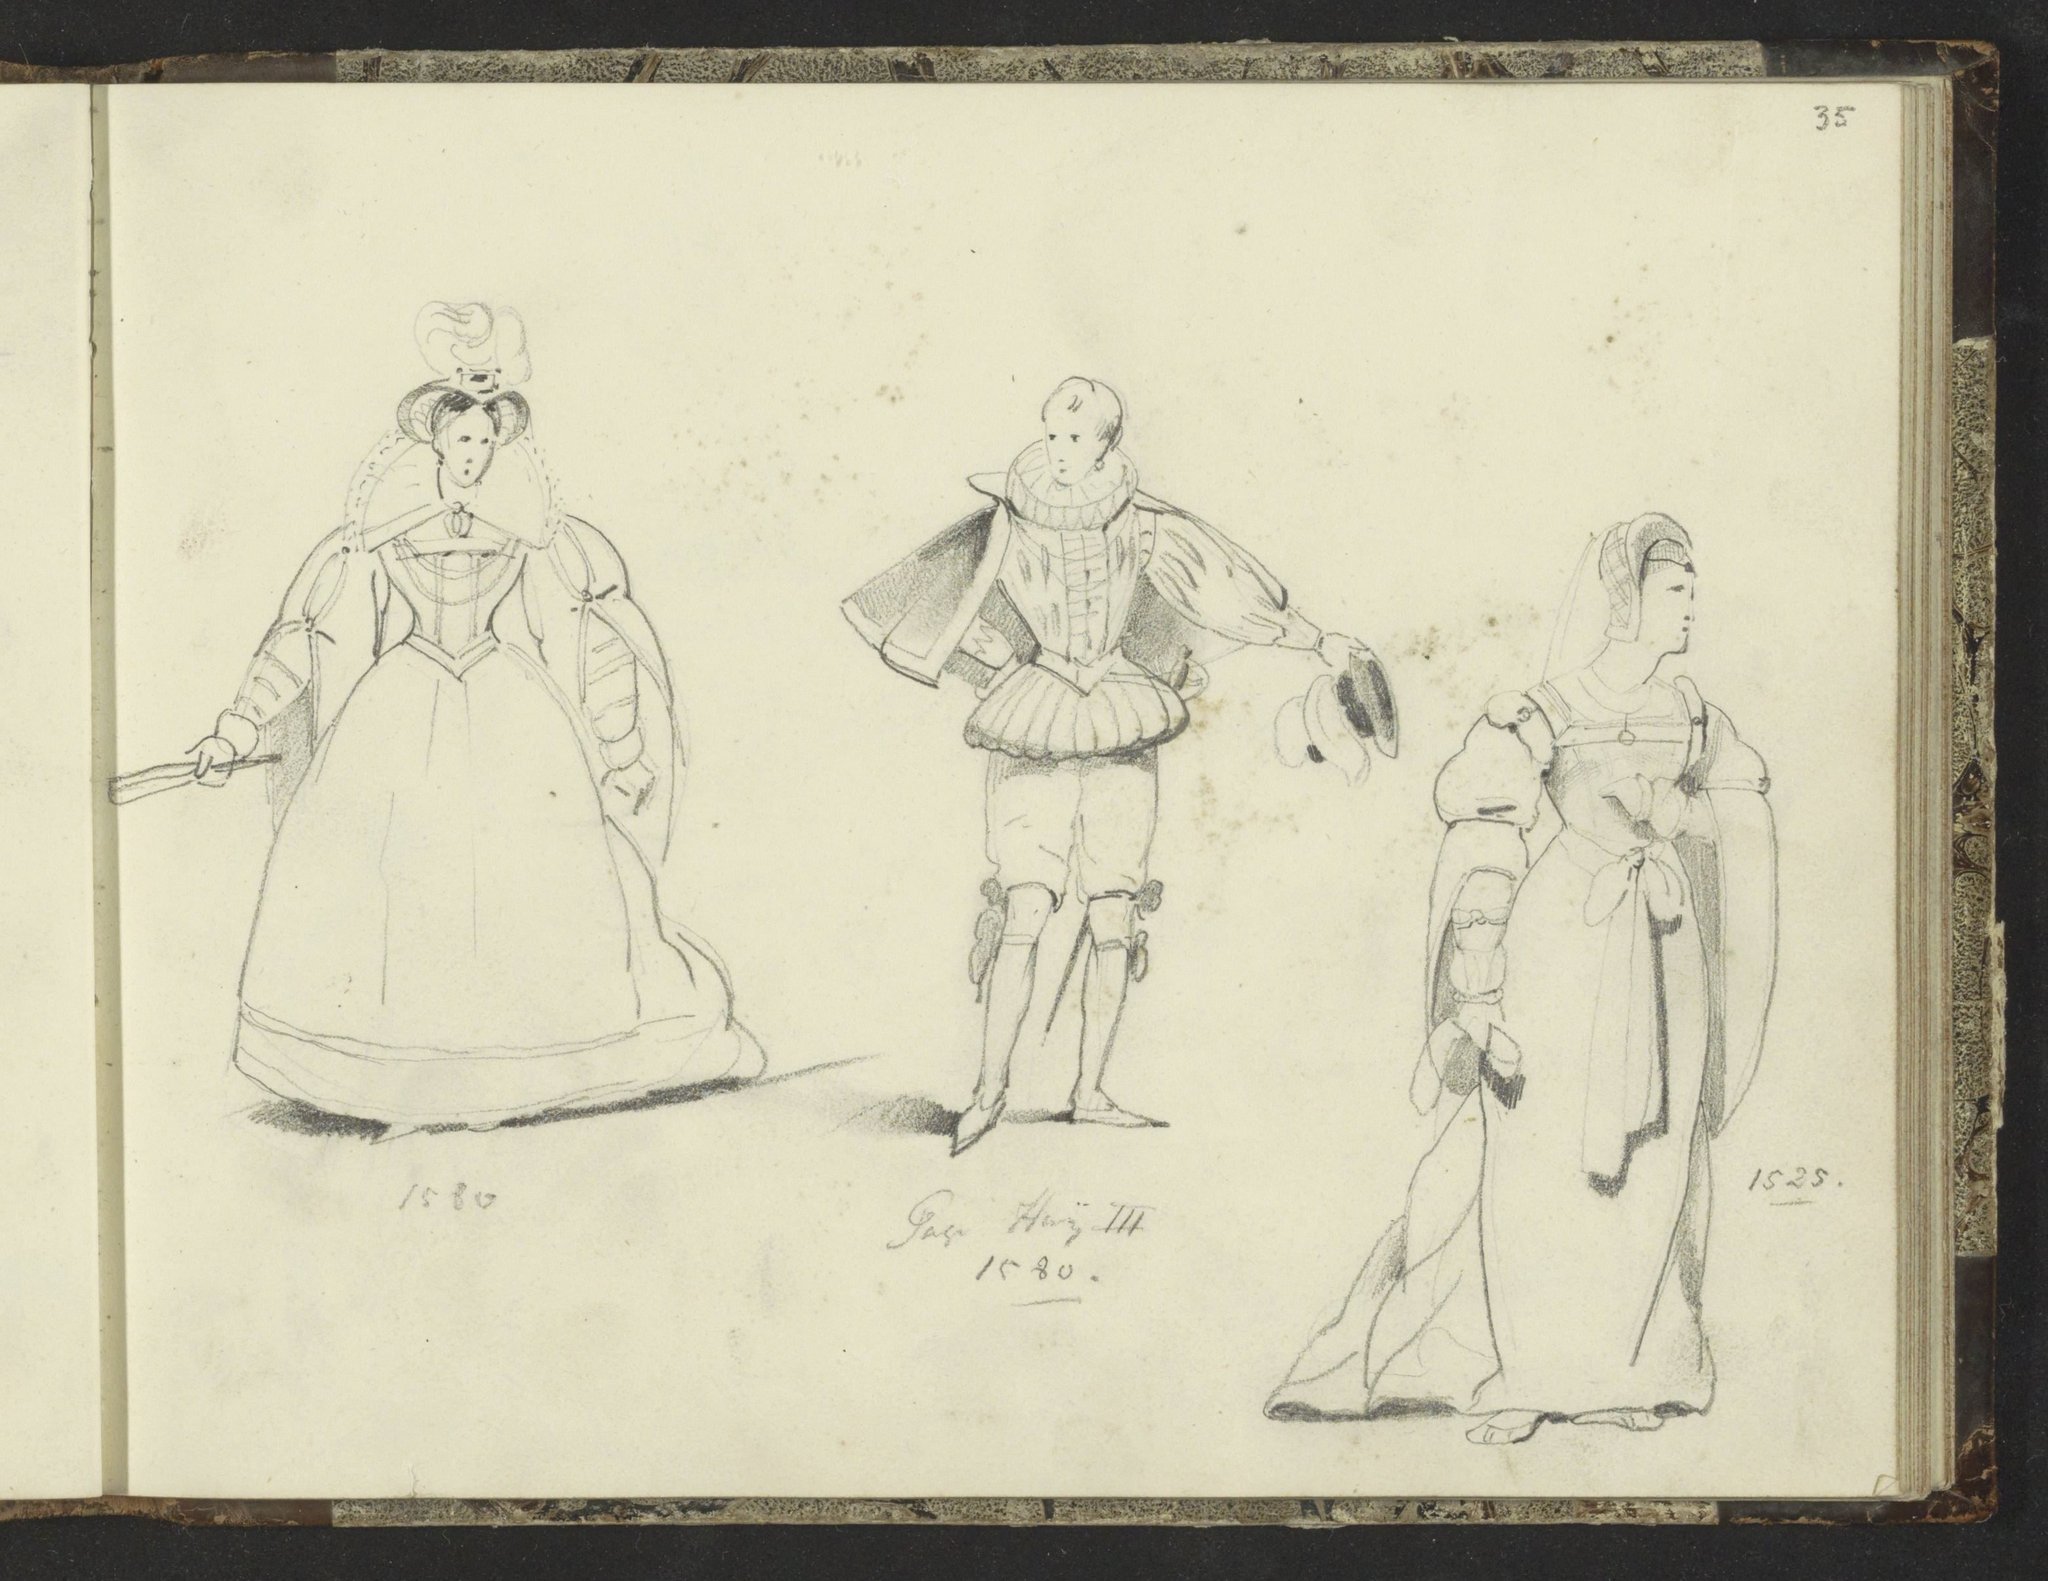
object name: sketchbook leaf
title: Page en vrouwen in kostuums uit de periode 1525-1580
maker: willem hendrik schmidt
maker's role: draughtsman, painter, print maker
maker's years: 1809-1849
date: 1819-1849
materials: paper, pencil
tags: historical costume, page, footboy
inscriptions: annotation: ‘1580/ Page H[...]ij III/ 1580./ 1525.’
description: Blad 35 recto uit een schetsboek met 58 bladen.